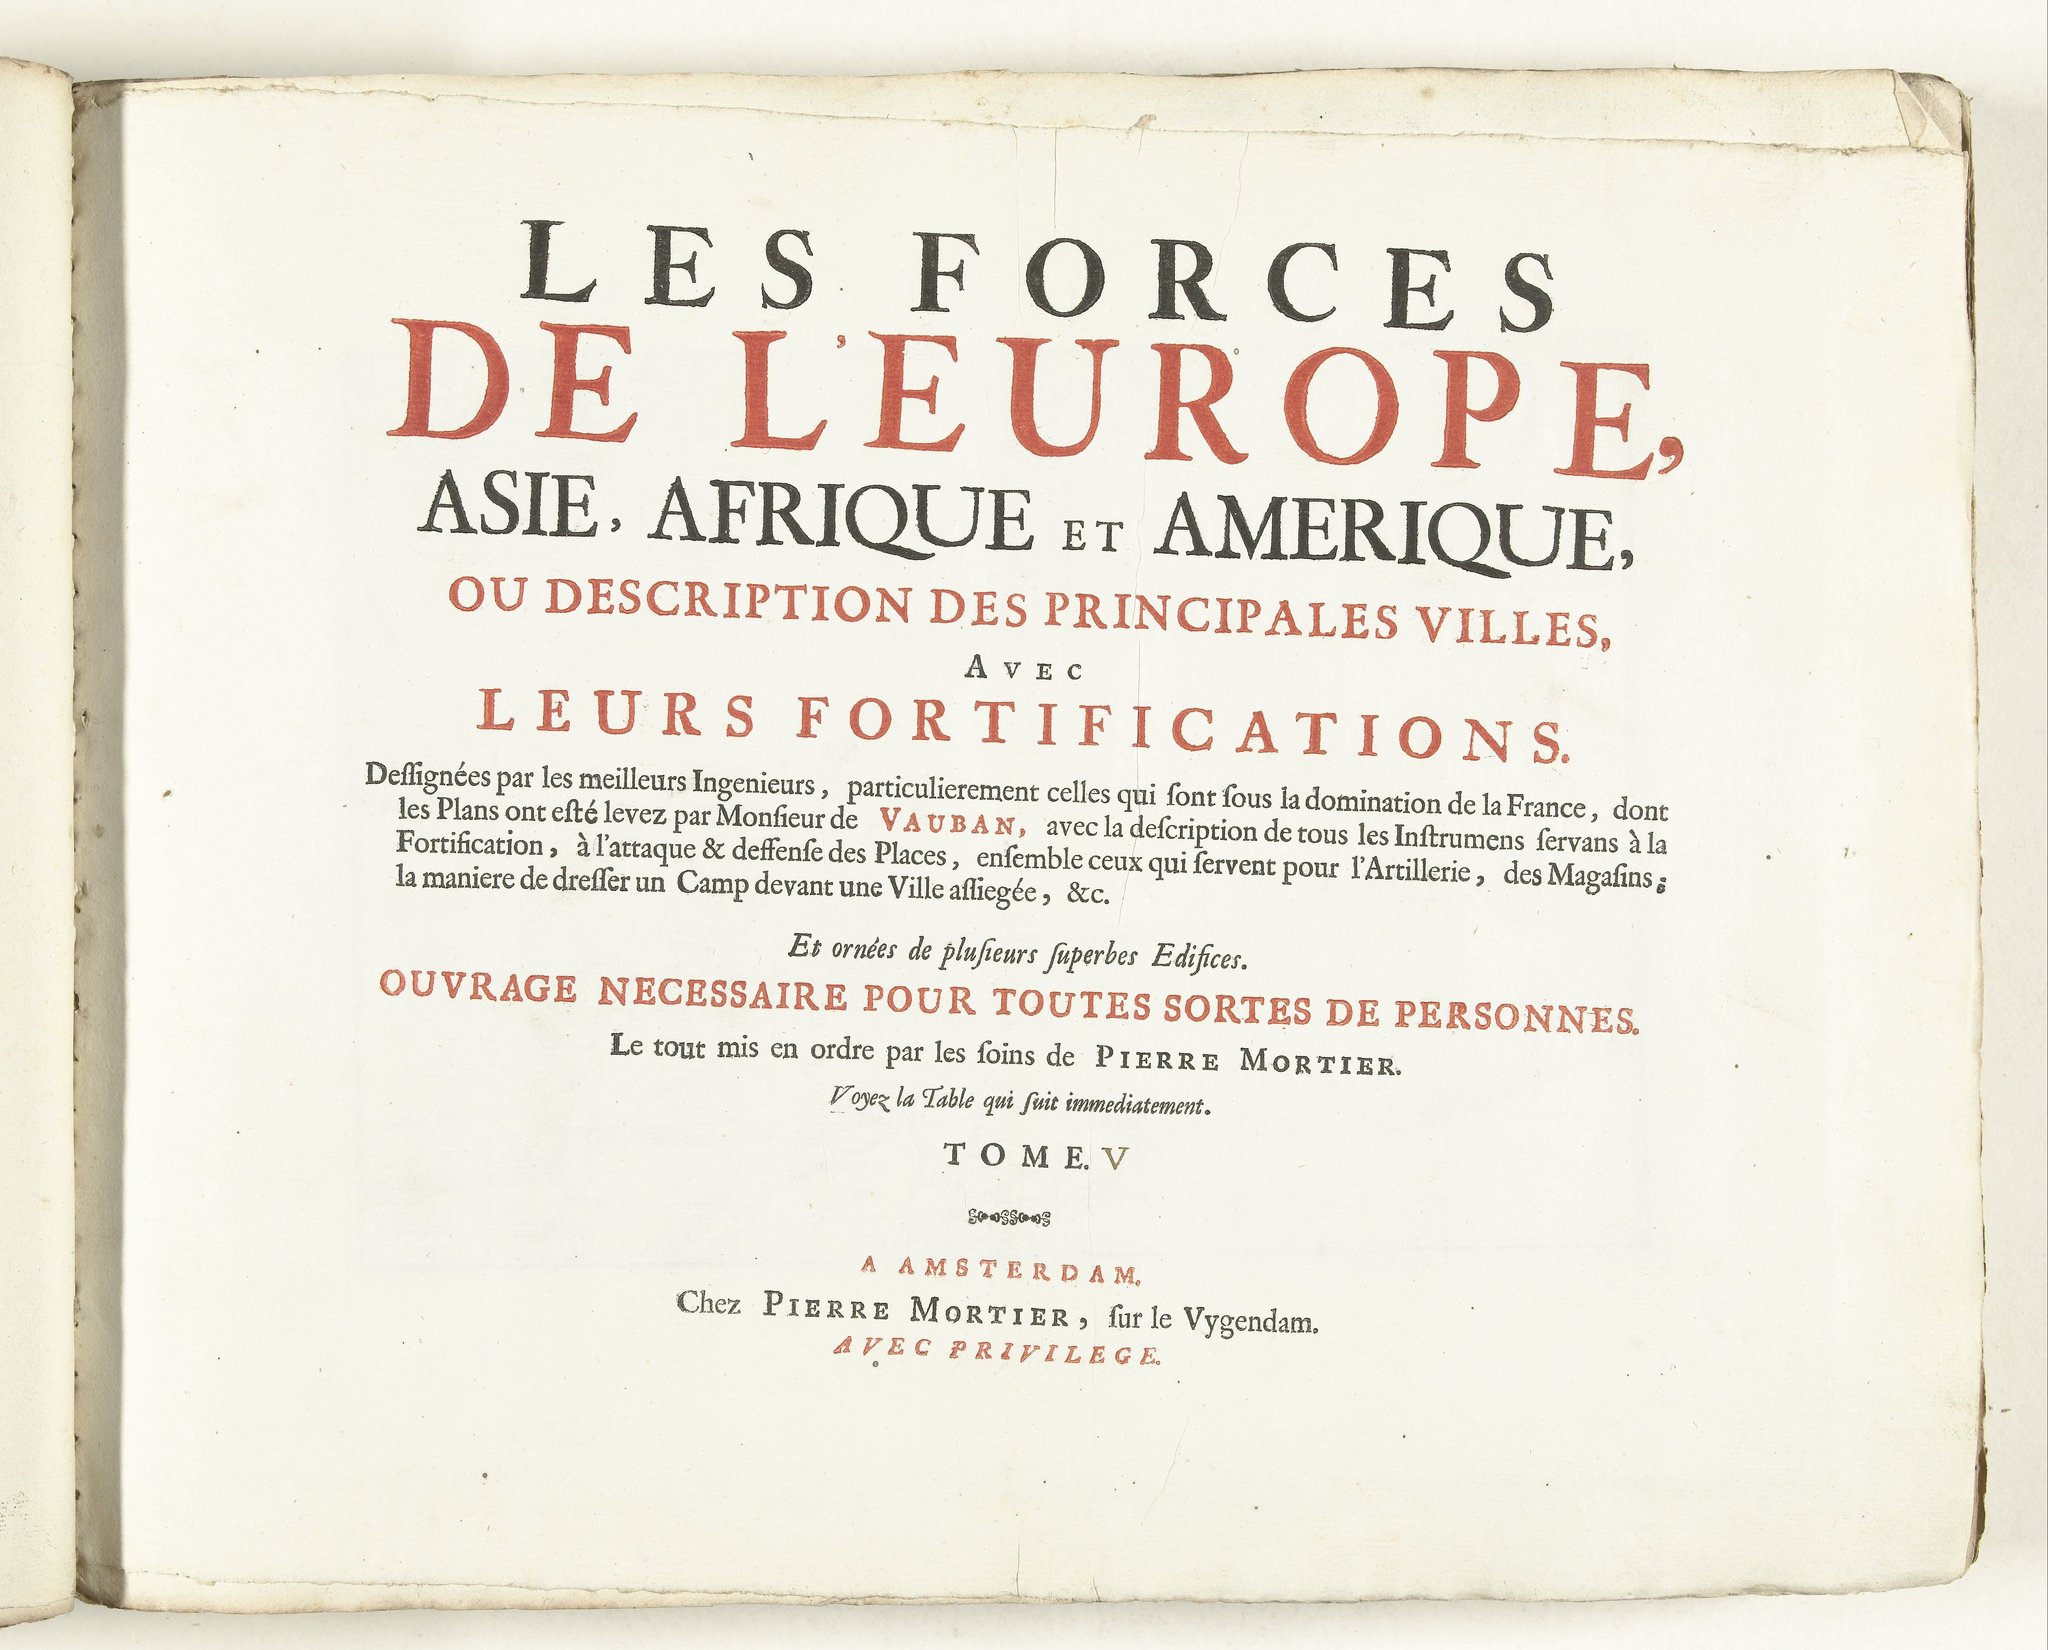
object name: titelblad, titelpagina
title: Titelpagina voor het vijfde deel van het prentwerk: Les Forces de l'Europe, Asie, Afrique et Amerique, ca. 1702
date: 1702-1703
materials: paper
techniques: letterpress printing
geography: amsterdam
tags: spaanse successieoorlog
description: Titelpagina gedrukt in zwart en rood voor het vijfde van twaalf delen van het prentwerk: Les Forces de l'Europe, Asie, Afrique et Amerique, uitgegeven ca. 1702. Ongenummerd [93]. Het prentwerk bestaat in totaal uit 276 genummerde platen van vermaarde sterke steden en vestingen in het kader van de Spaanse Successieoorlog. Voor het merendeel zijn deze platen gekopieerd naar de anonieme Franse platen: in Les forces de l'Europe en in: Le theatre de la guerre, dans les Pays-Bas, beide oorspronkelijk uitgegeven door Nicolas de Fer te Parijs (1693-1697) in het kader van de Negenjarige Oorlog. Titel in het Frans.